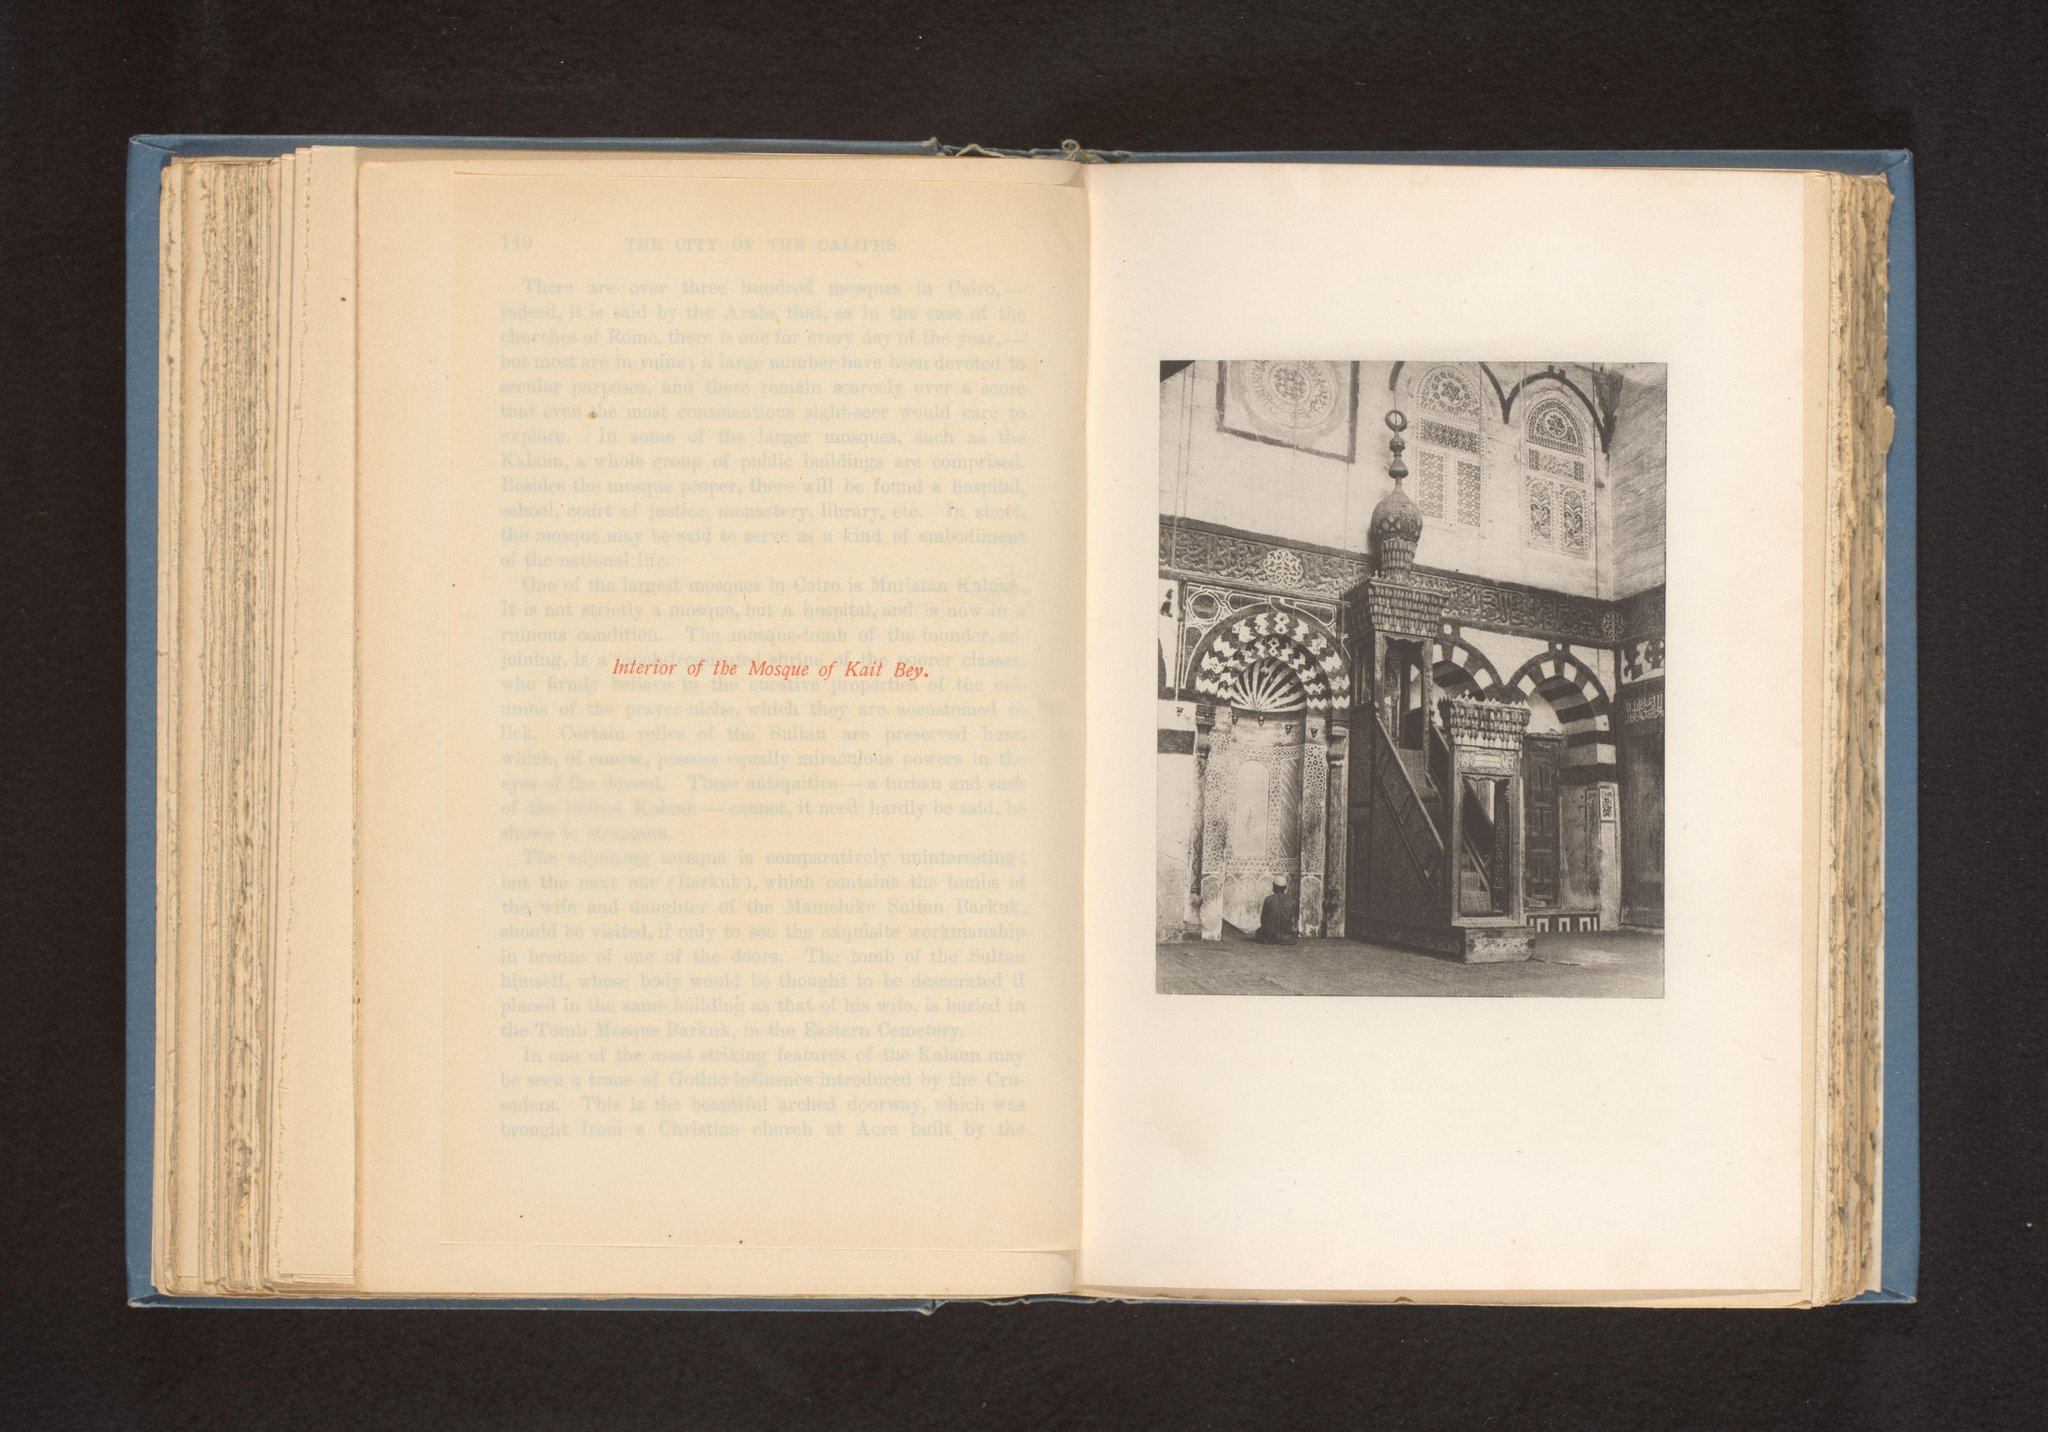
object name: page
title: Interieur van de moskee van sultan al-Ashraf Qaitbey te Caïro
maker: Anonymous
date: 1887-1897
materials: paper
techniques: photoaquatint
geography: moskee van sultan al-ashraf qaitbey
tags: temple, shrine ~ islam, mohammedanism, interior ~ representation of a building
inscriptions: title: ‘Interior of the Mosque of Kait Bey.’